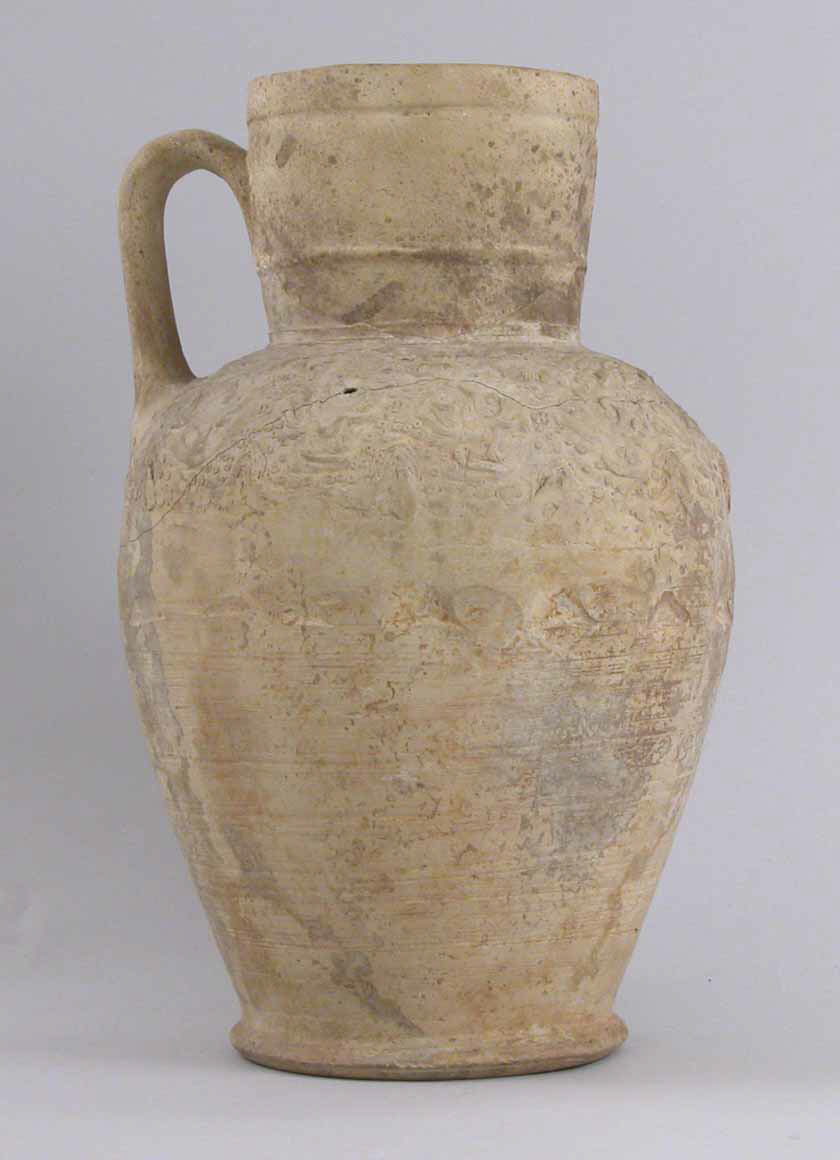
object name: jar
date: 1101-1200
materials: earthenware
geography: syria